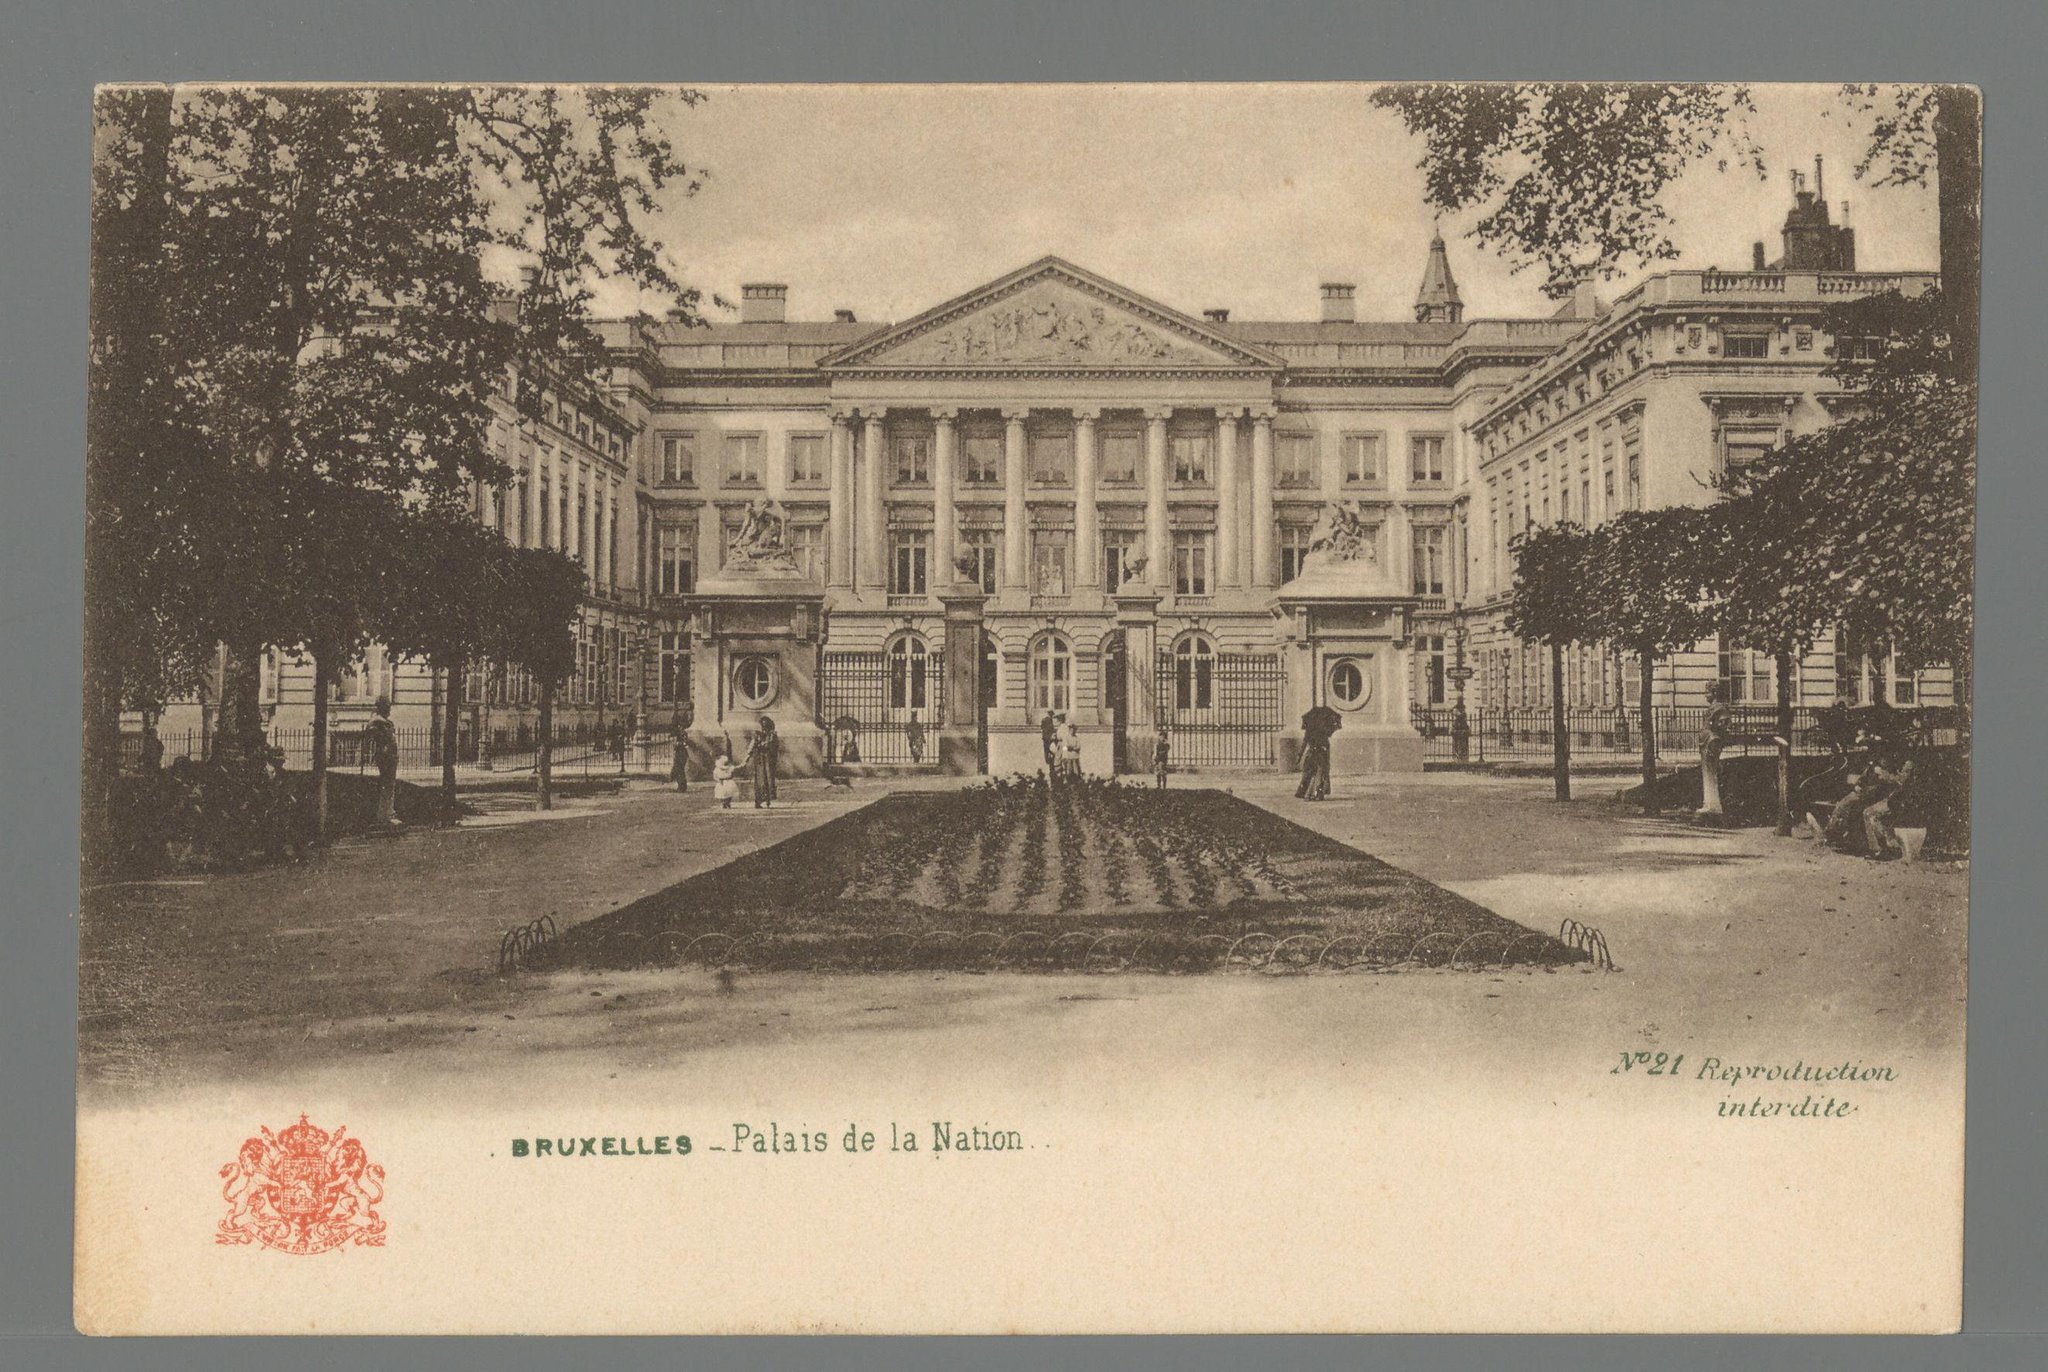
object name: ansichtkaart, prentbriefkaart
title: Bruxelles. Palais de la Nation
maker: Anonymous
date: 1903-1906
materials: cardboard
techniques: photograph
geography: brussels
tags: public gardens, park, lower house, parliament, chamber, edifice, e.g.: public building, department store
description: Onder staat: No. 21 Reproduction interdite.